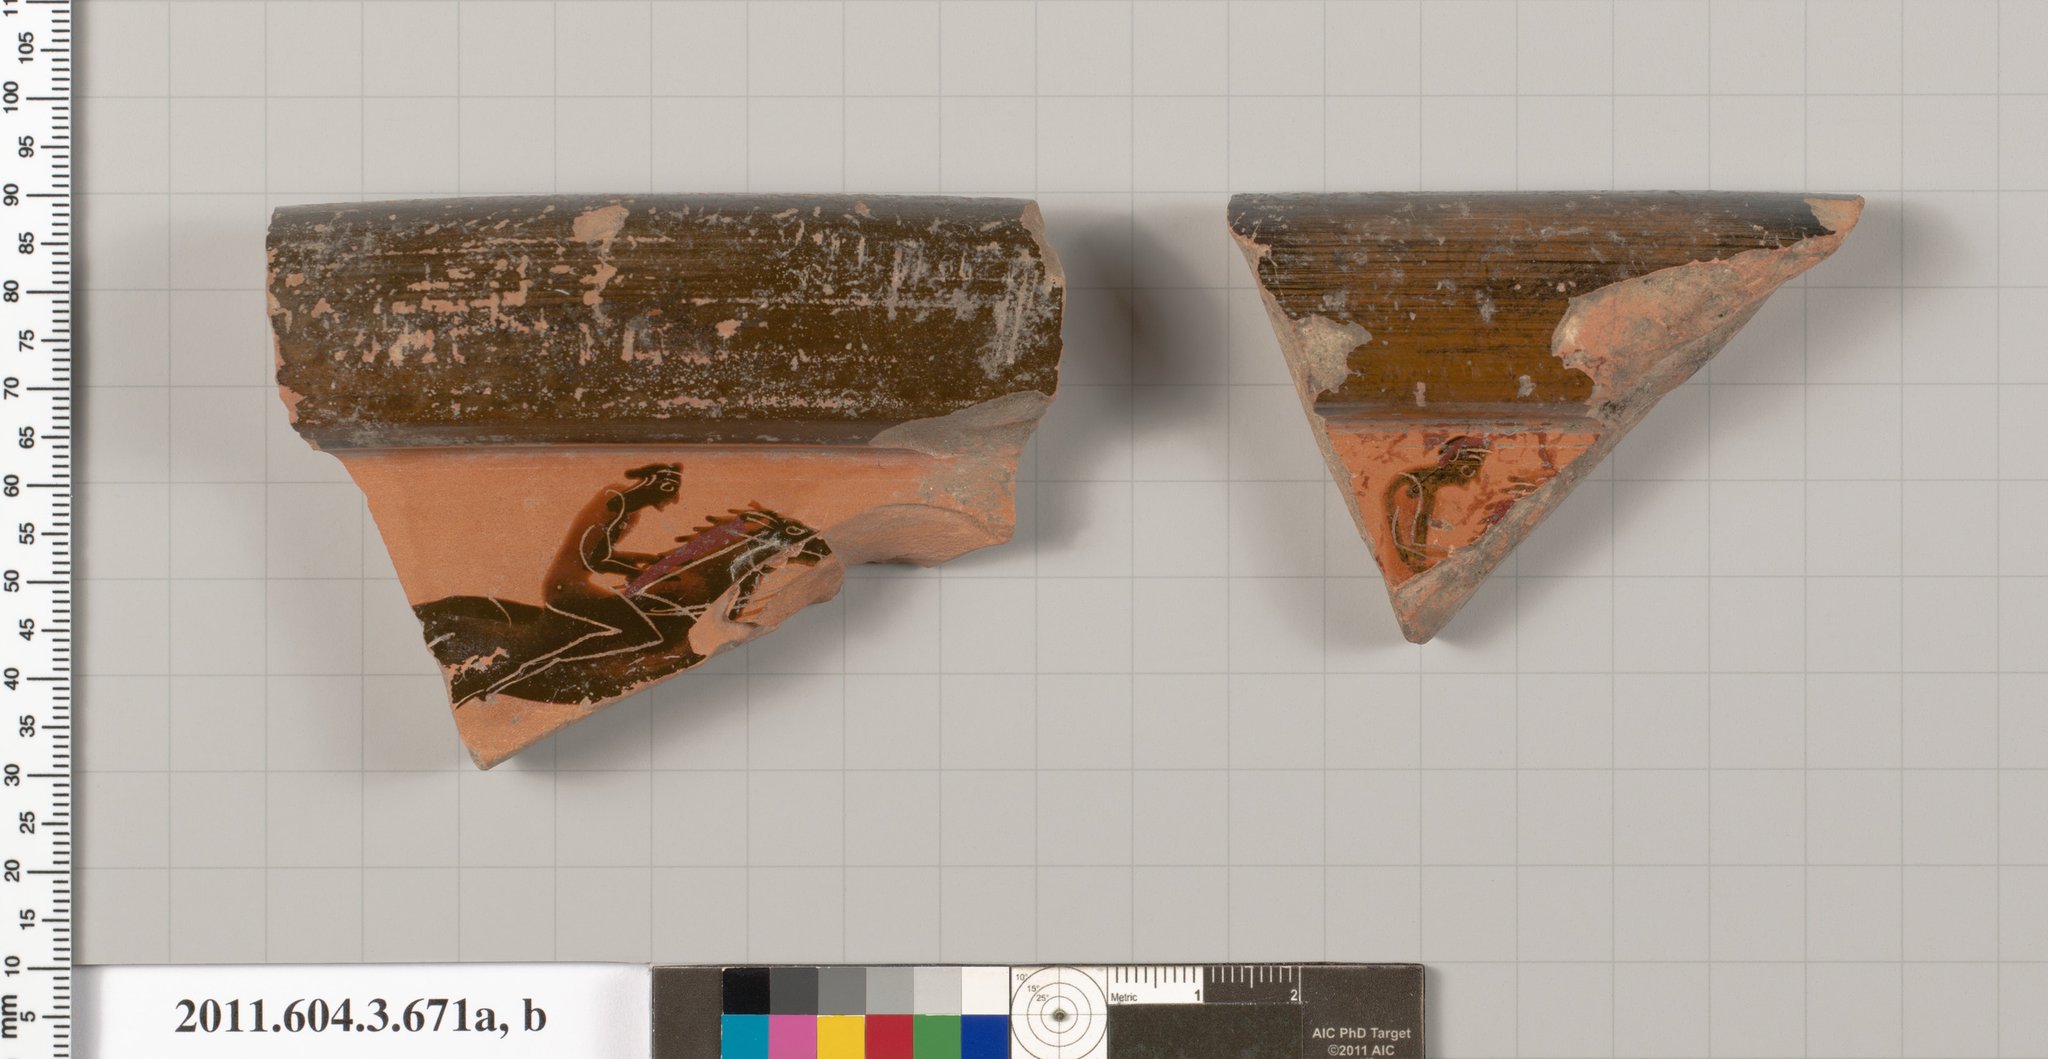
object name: calyx krater fragment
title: Terracotta fragments of a calyx-krater (bowl for mixing wine and water)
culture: greek, attic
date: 525-501 BCE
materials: terracotta